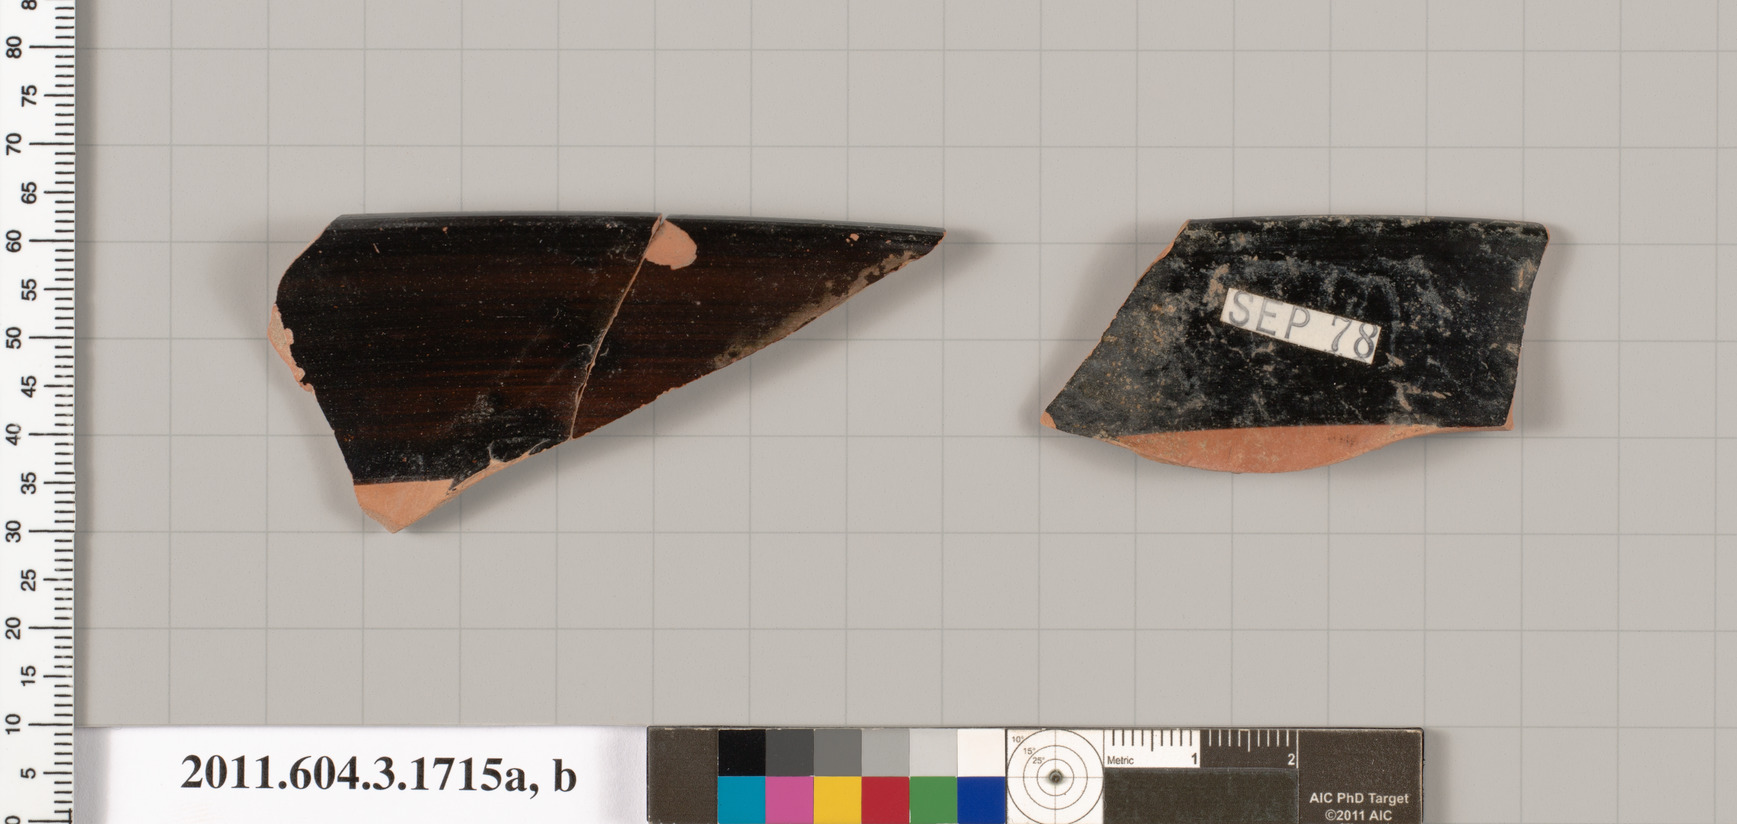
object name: kylix fragment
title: Terracotta rim fragments of kylikes: Band cups (drinking cups)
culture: greek, attic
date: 550-526 BCE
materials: terracotta